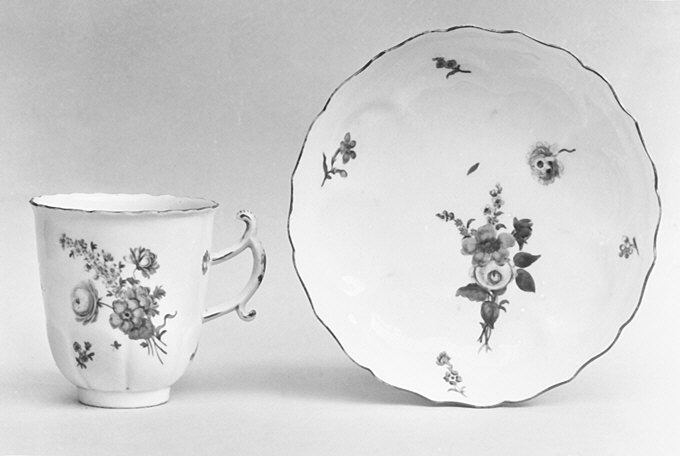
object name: cup and saucer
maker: meissen manufactory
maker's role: manufactory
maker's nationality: german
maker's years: 1710-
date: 1750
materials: hard paste porcelain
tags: flowers